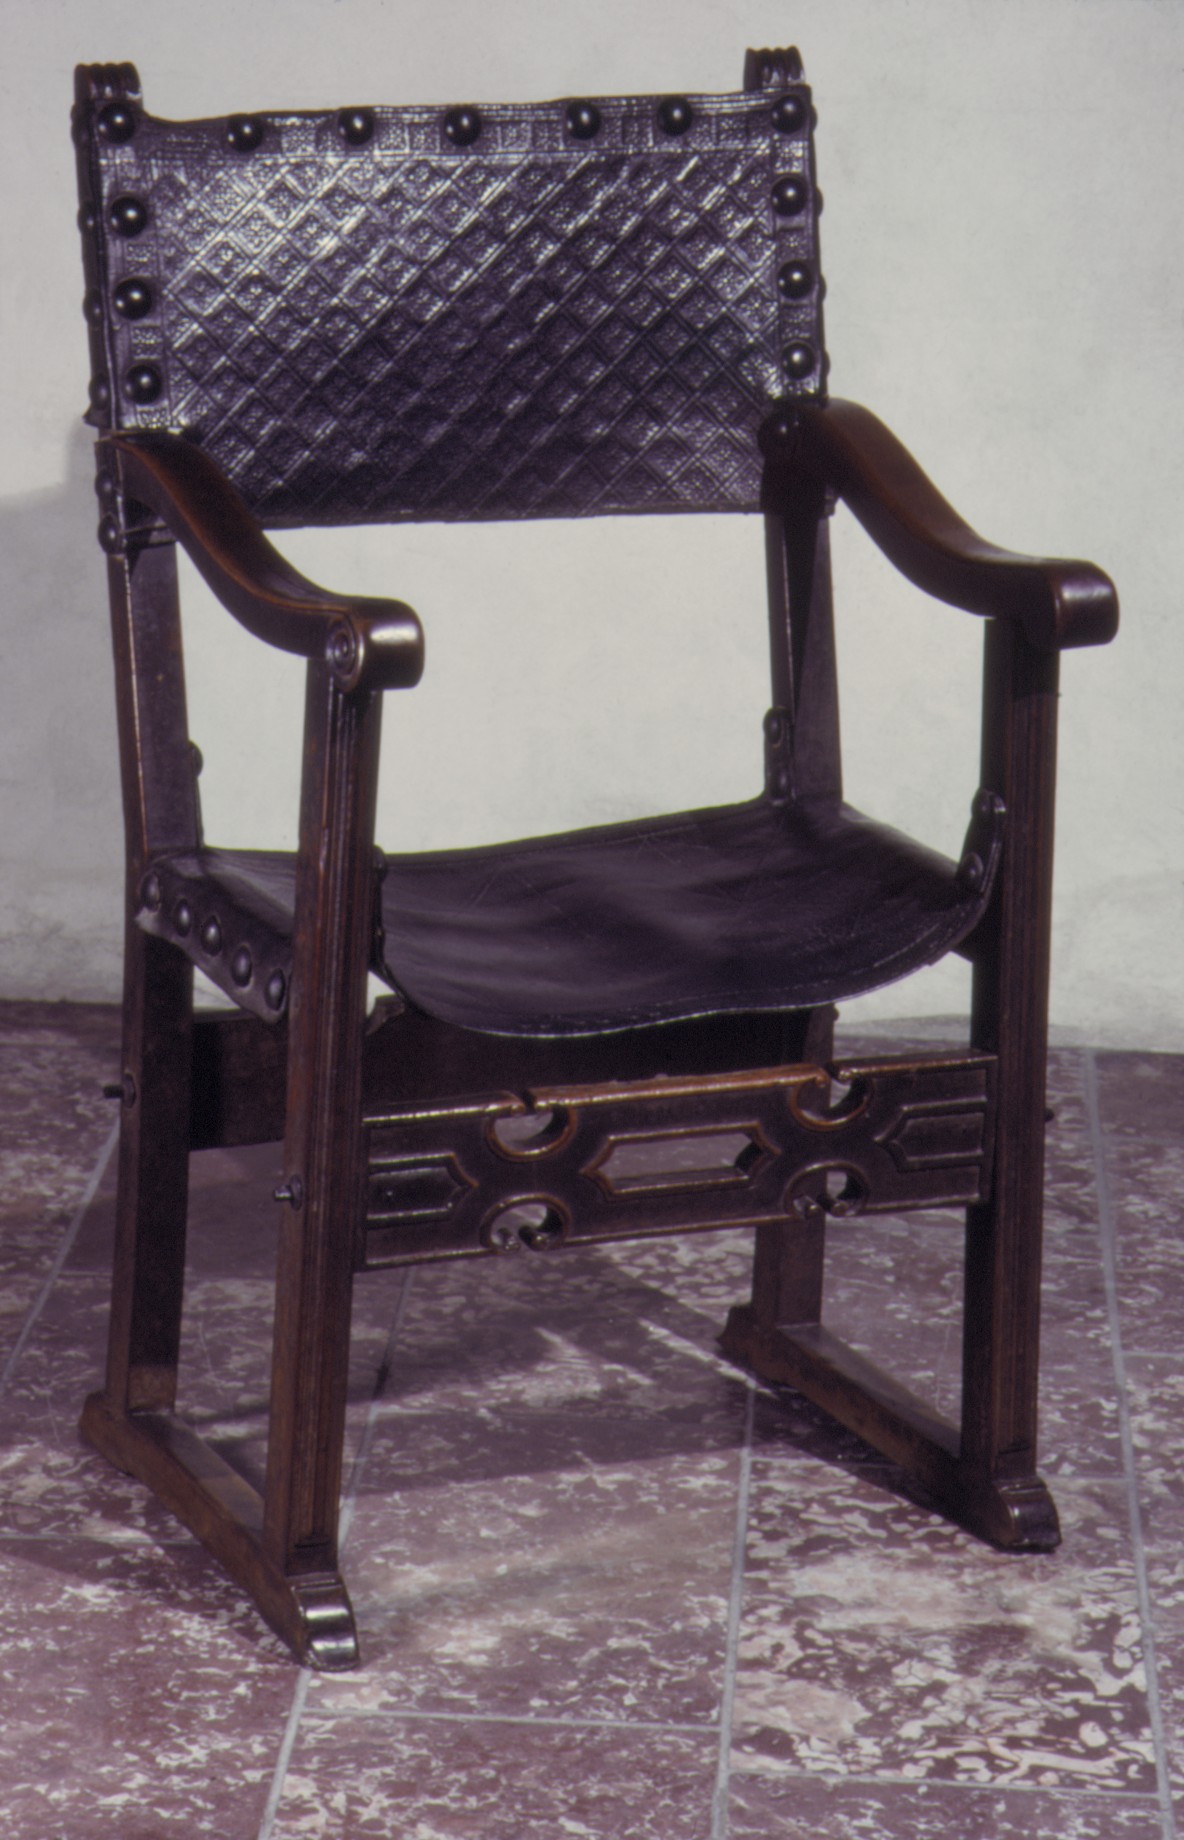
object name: armchair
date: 1501-1600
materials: leather, wood